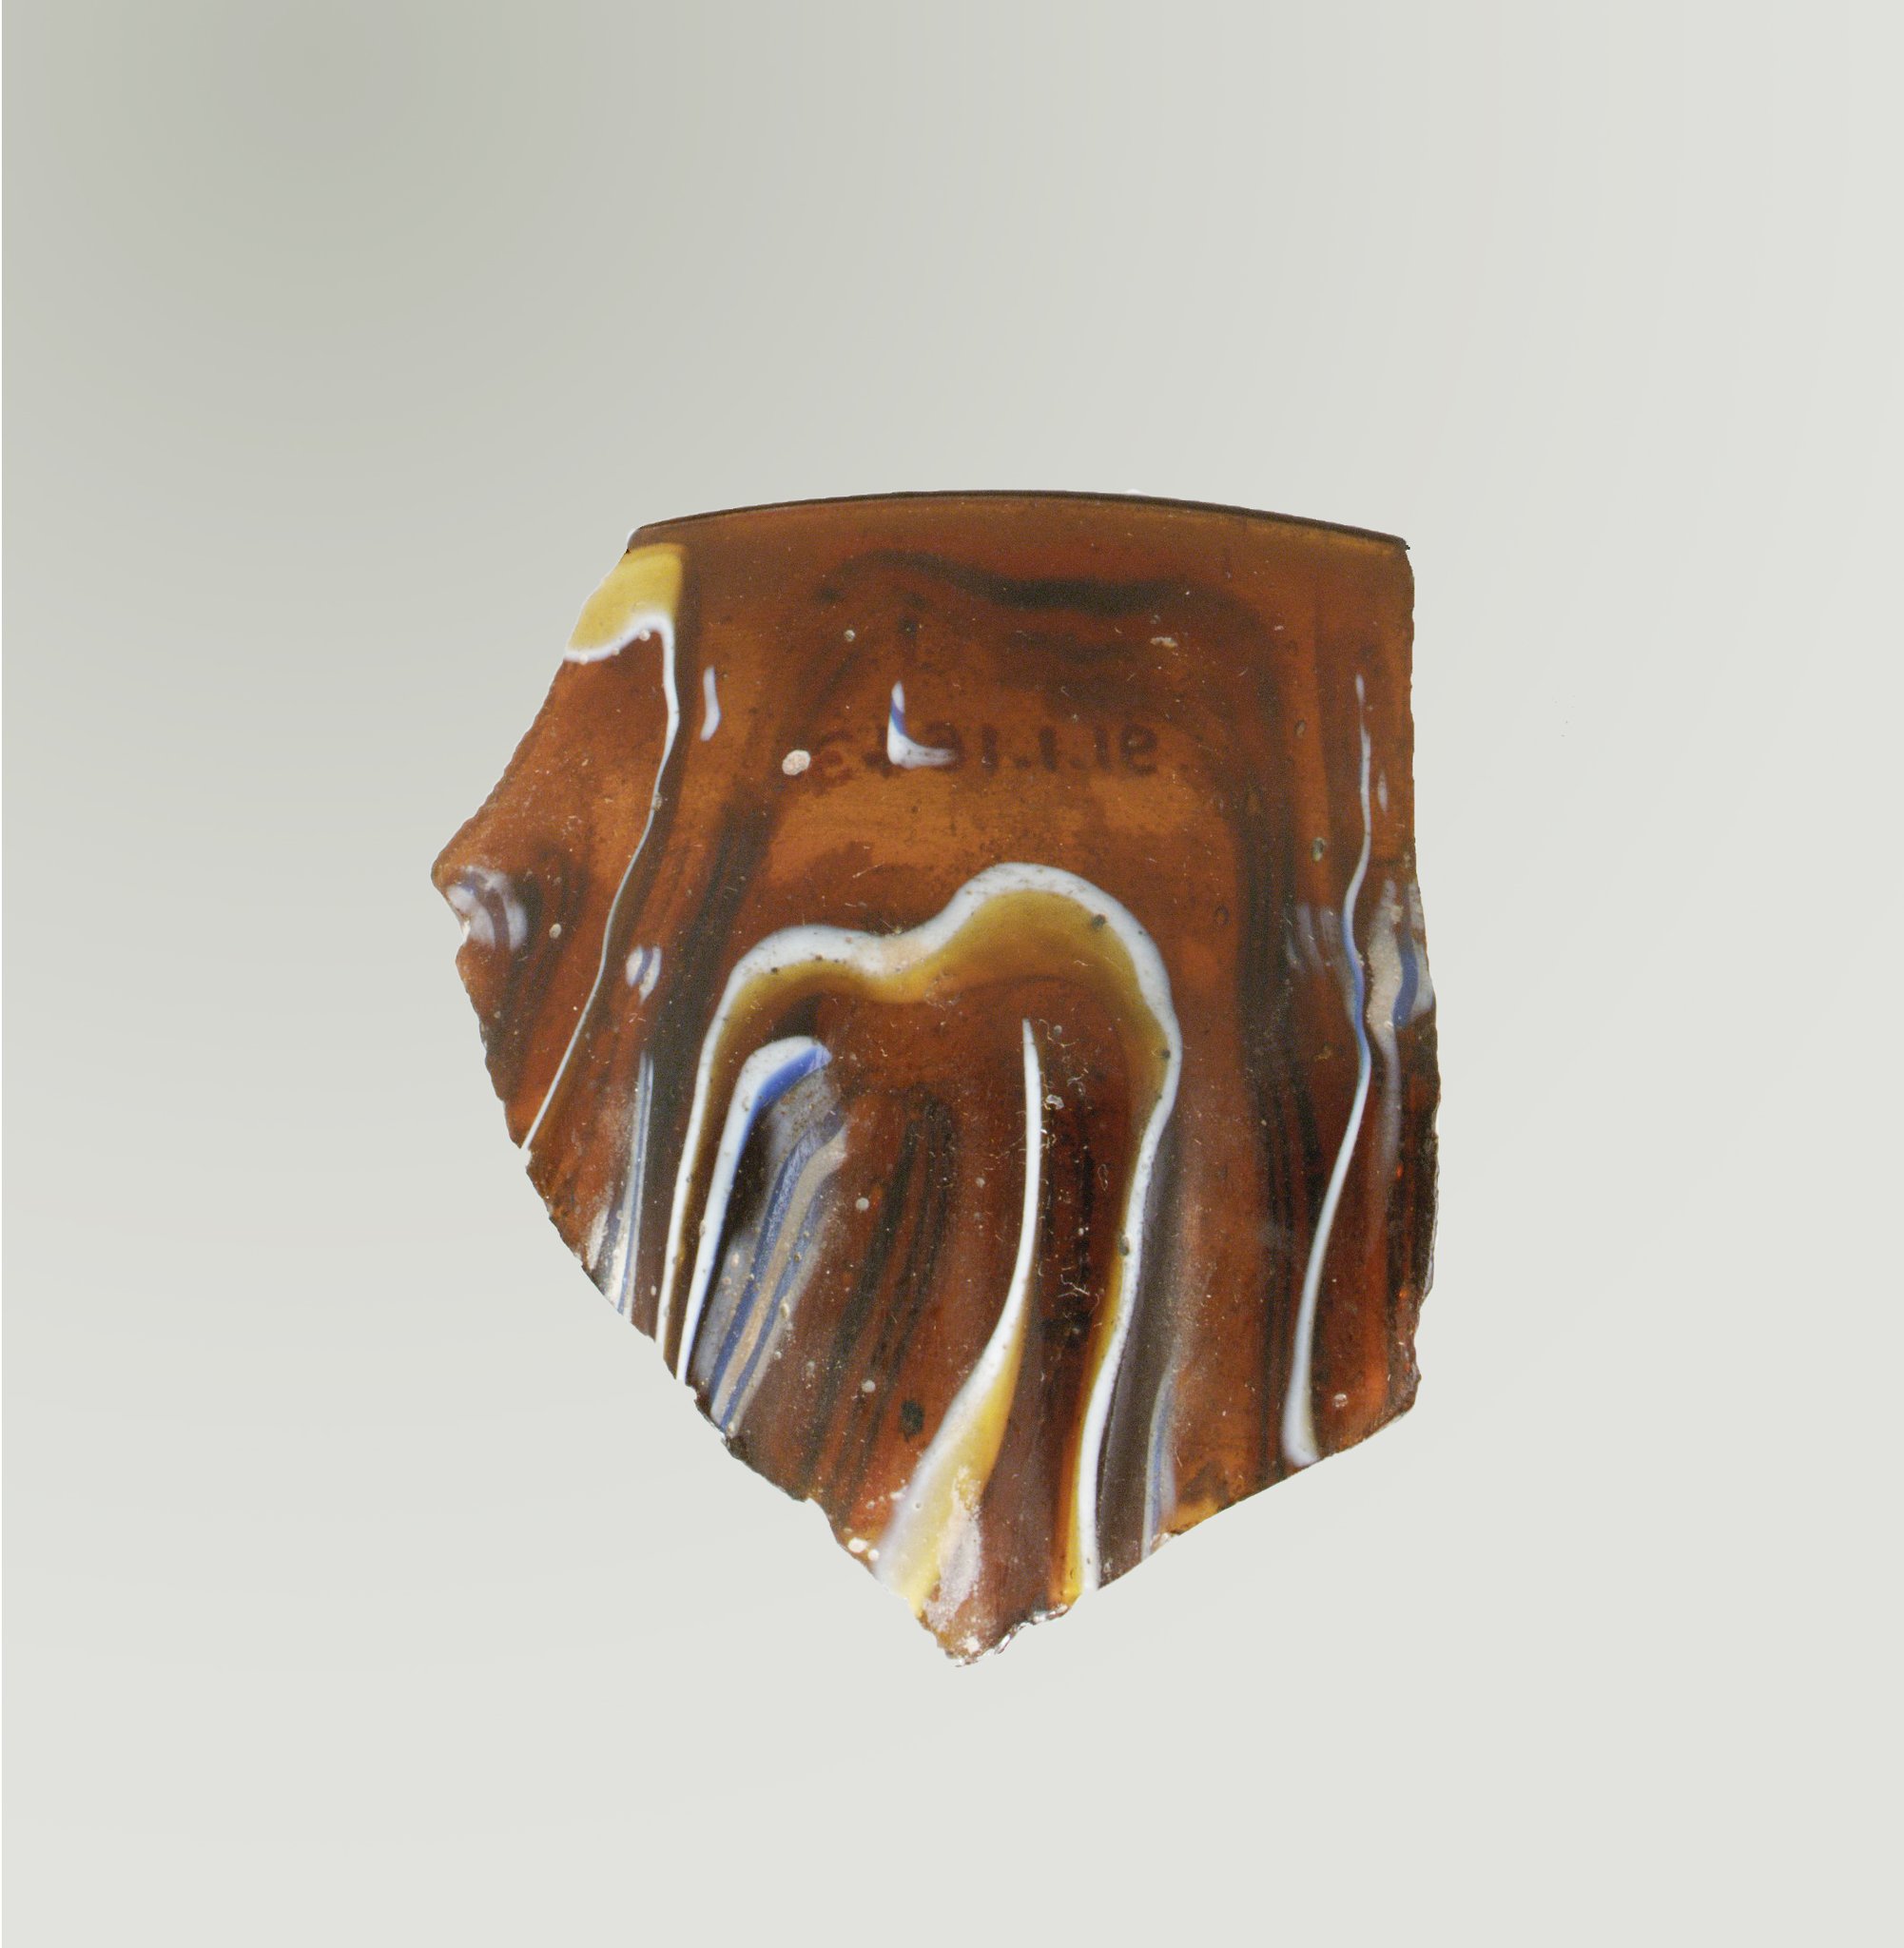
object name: mosaic bowl, fragment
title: Glass mosaic ribbed bowl fragment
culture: roman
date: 34 BCE-33 CE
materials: glass